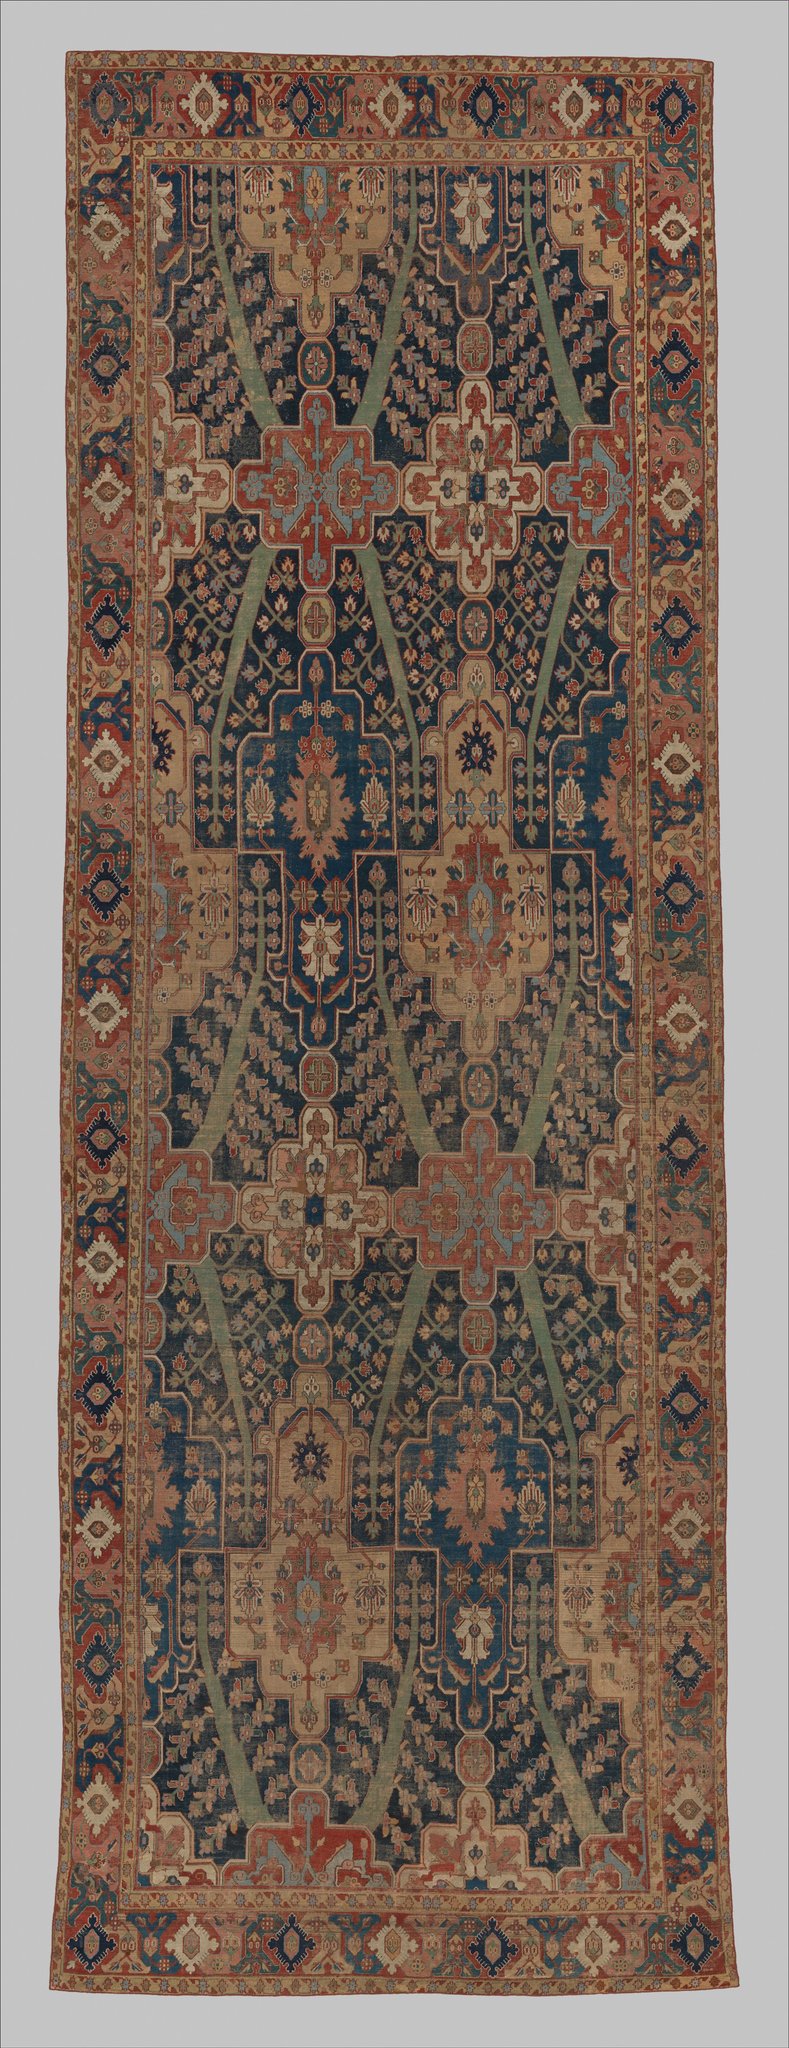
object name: carpet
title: Carpet with Tree and Cartouche Design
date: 1701-1800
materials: cotton, wool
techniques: asymmetrically knotted pile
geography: iran